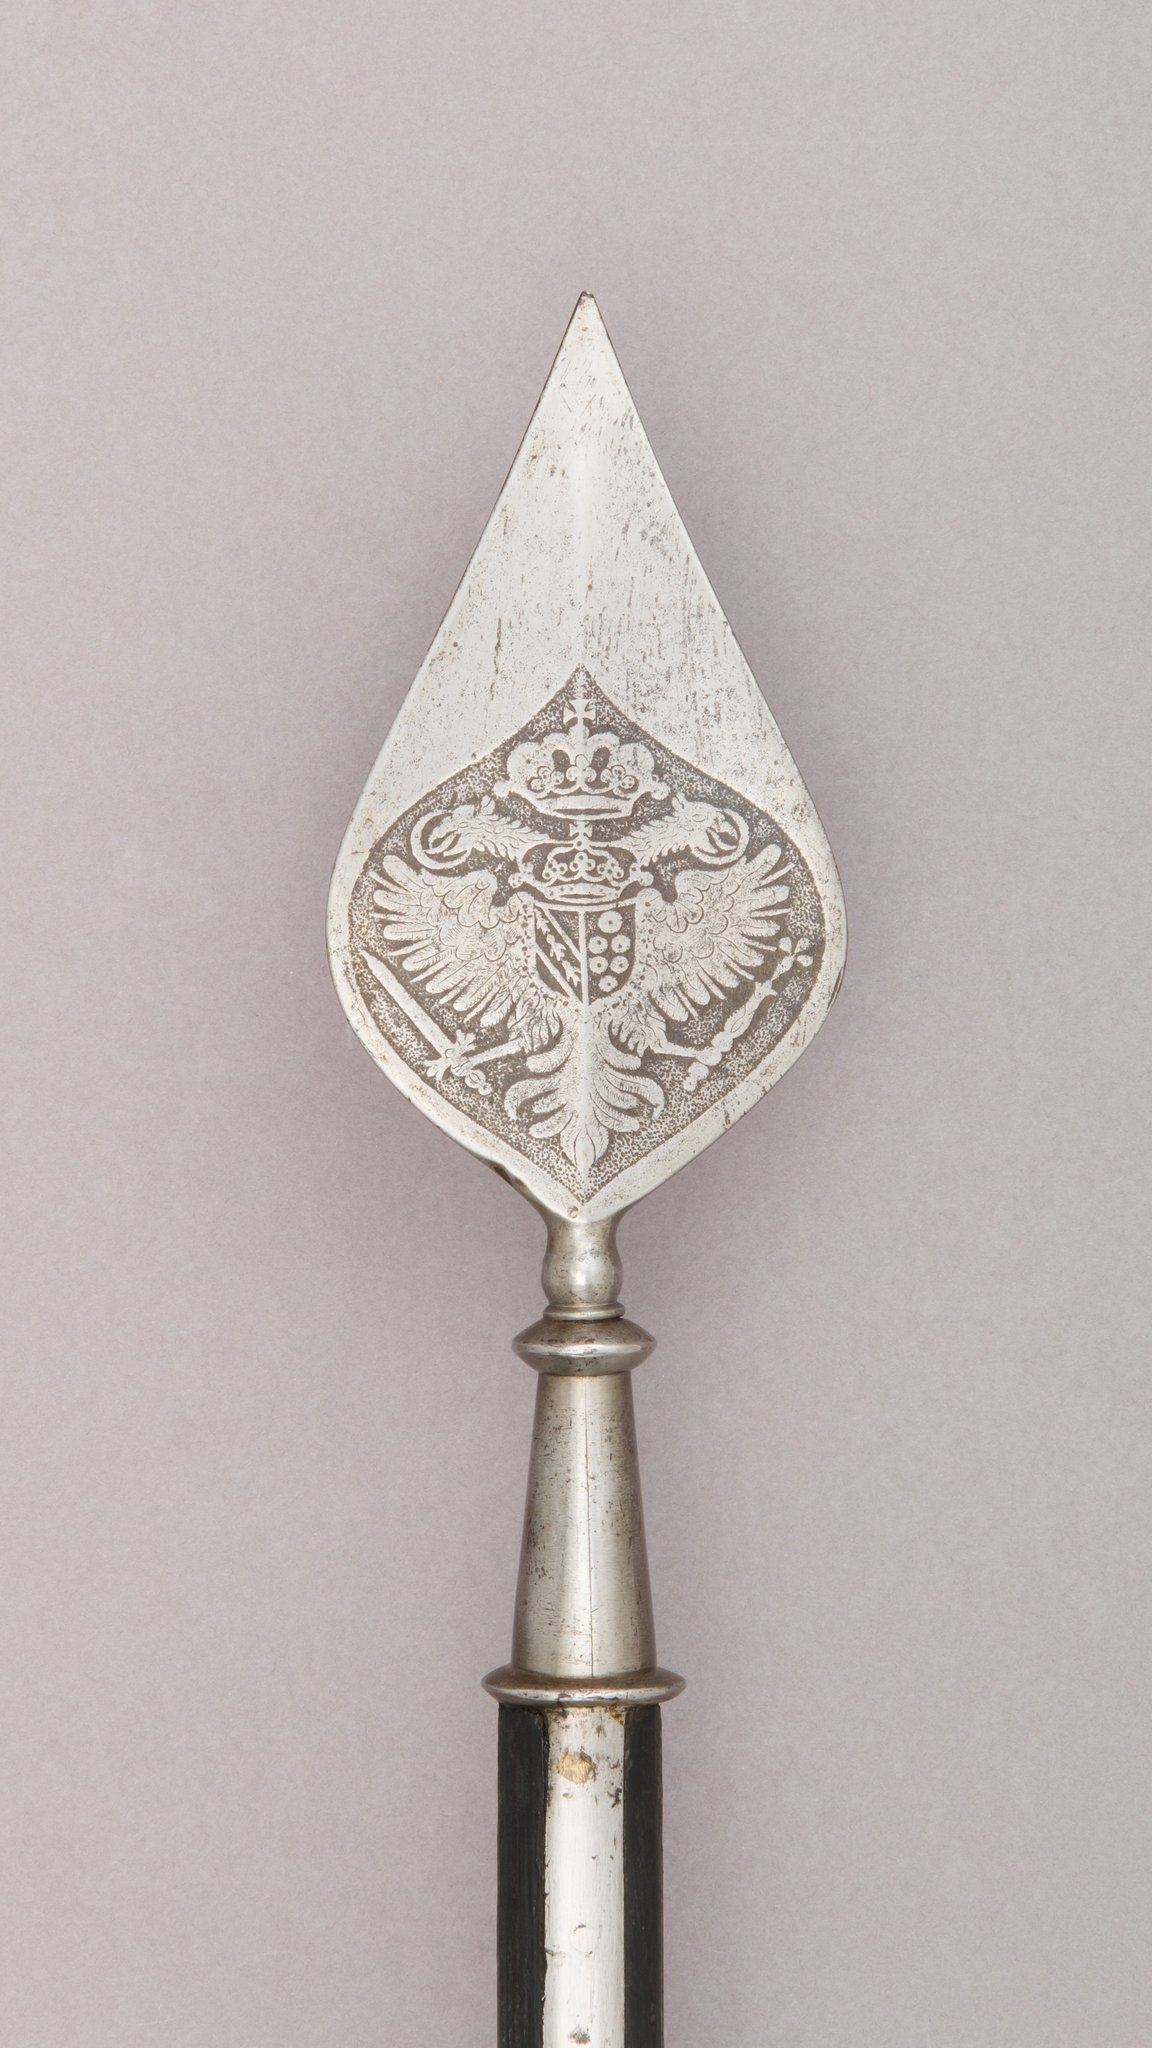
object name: lance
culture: austrian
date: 1701-1800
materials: gold, steel, wood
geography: austria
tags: eagles,coat of arms